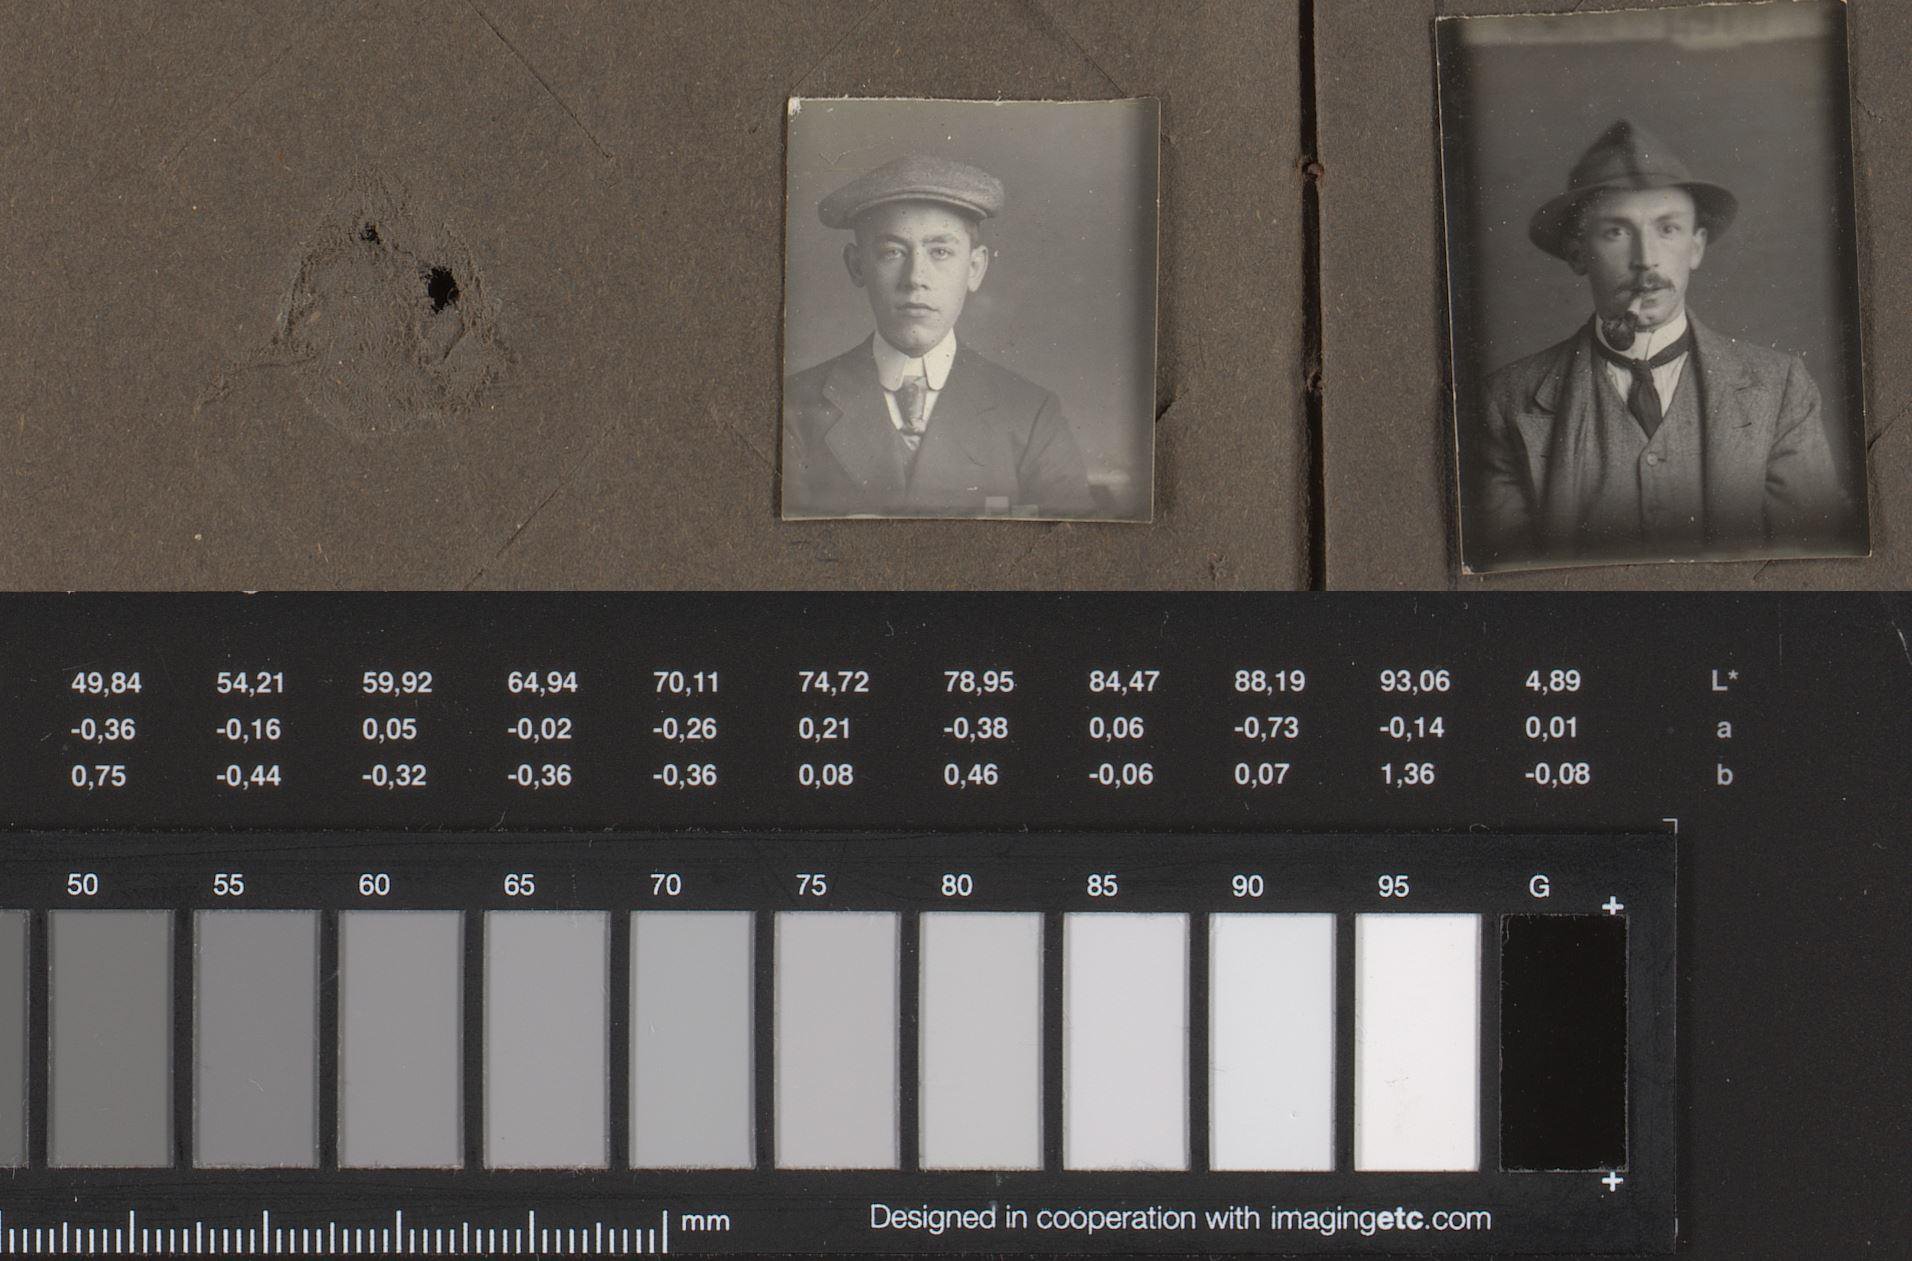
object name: album leaf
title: Portret van een onbekende jonge man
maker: Anonymous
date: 1912-1916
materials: paper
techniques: gelatin silver print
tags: anonymous historical person portrayed